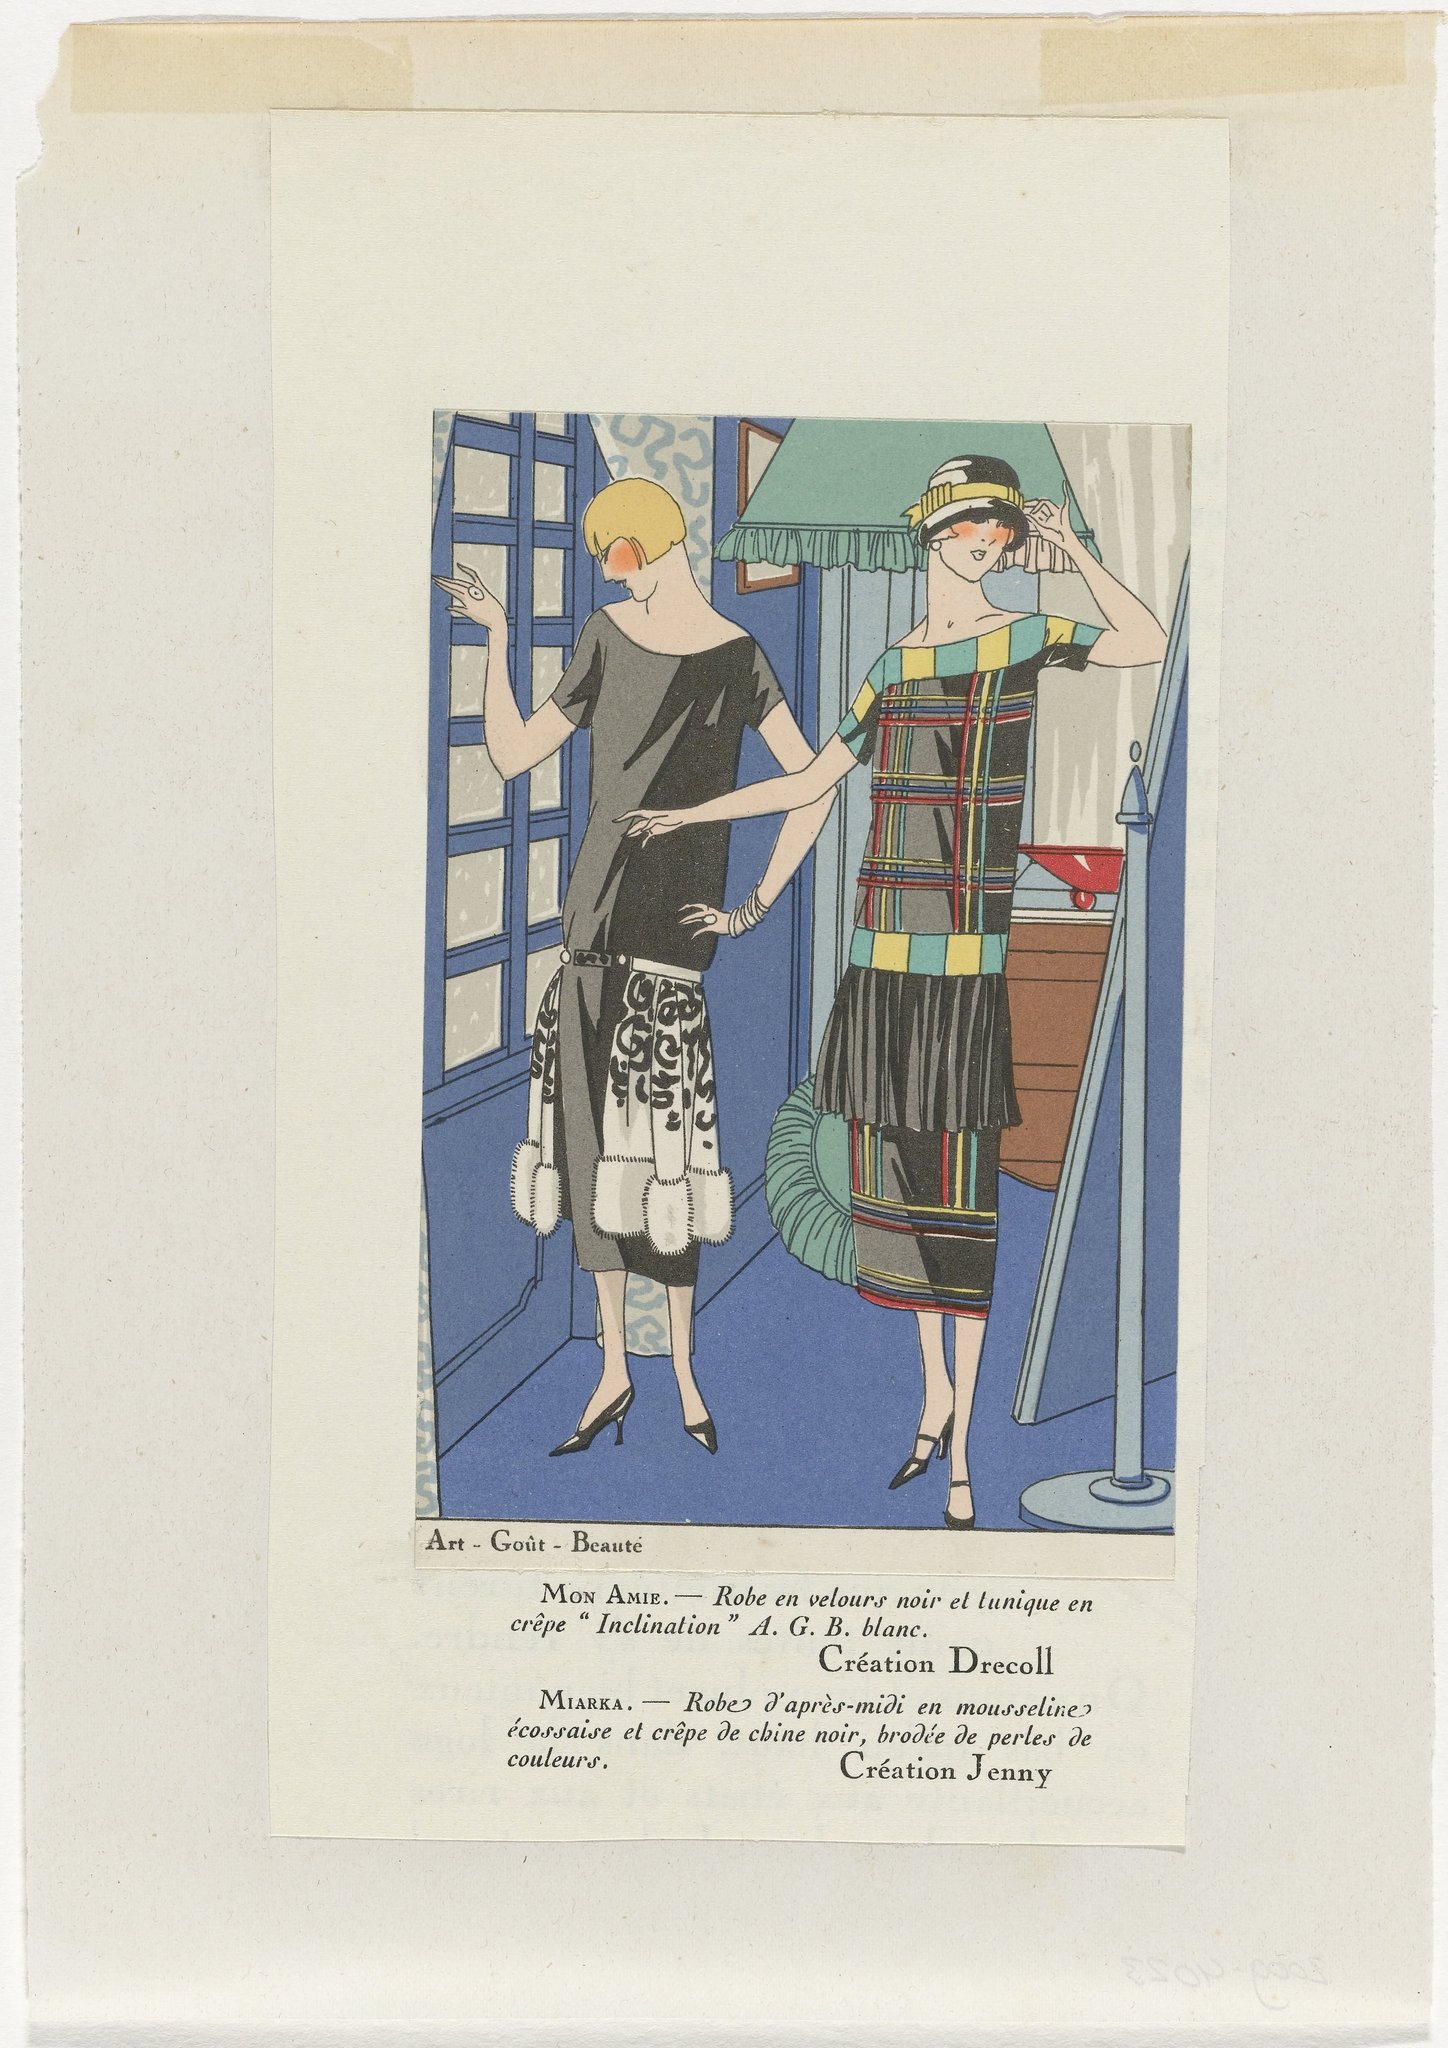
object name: fashion print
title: Art-Goût-Beauté, 1924 (ca.) : Mon Amie.- Robe en velours (...)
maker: Anonymous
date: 1924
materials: paper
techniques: engraving, letterpress printing, pochoir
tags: dress, gown (afternoon dress) (+ women's clothes), fashion plates, dress, gown (+ women's clothes)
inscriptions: title: ‘Art-Goût-Beauté’, caption: ‘Mon Amie. - robe en velours noir et tunique en crêpe "Inclination"A.G.B. blanc. / Création Drecoll / Miarka. - robe dáprès-midi en mousseline écossaise et crêpe de chine noir, brodée de perles de couleurs. / Création Jenny’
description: Japon van zwart fluweel en tuniek van Drecoll. Middagjapon van mousseline van Jenny. Prent uit het modetijdschrift Art-Goût-Beauté (1920-1933).